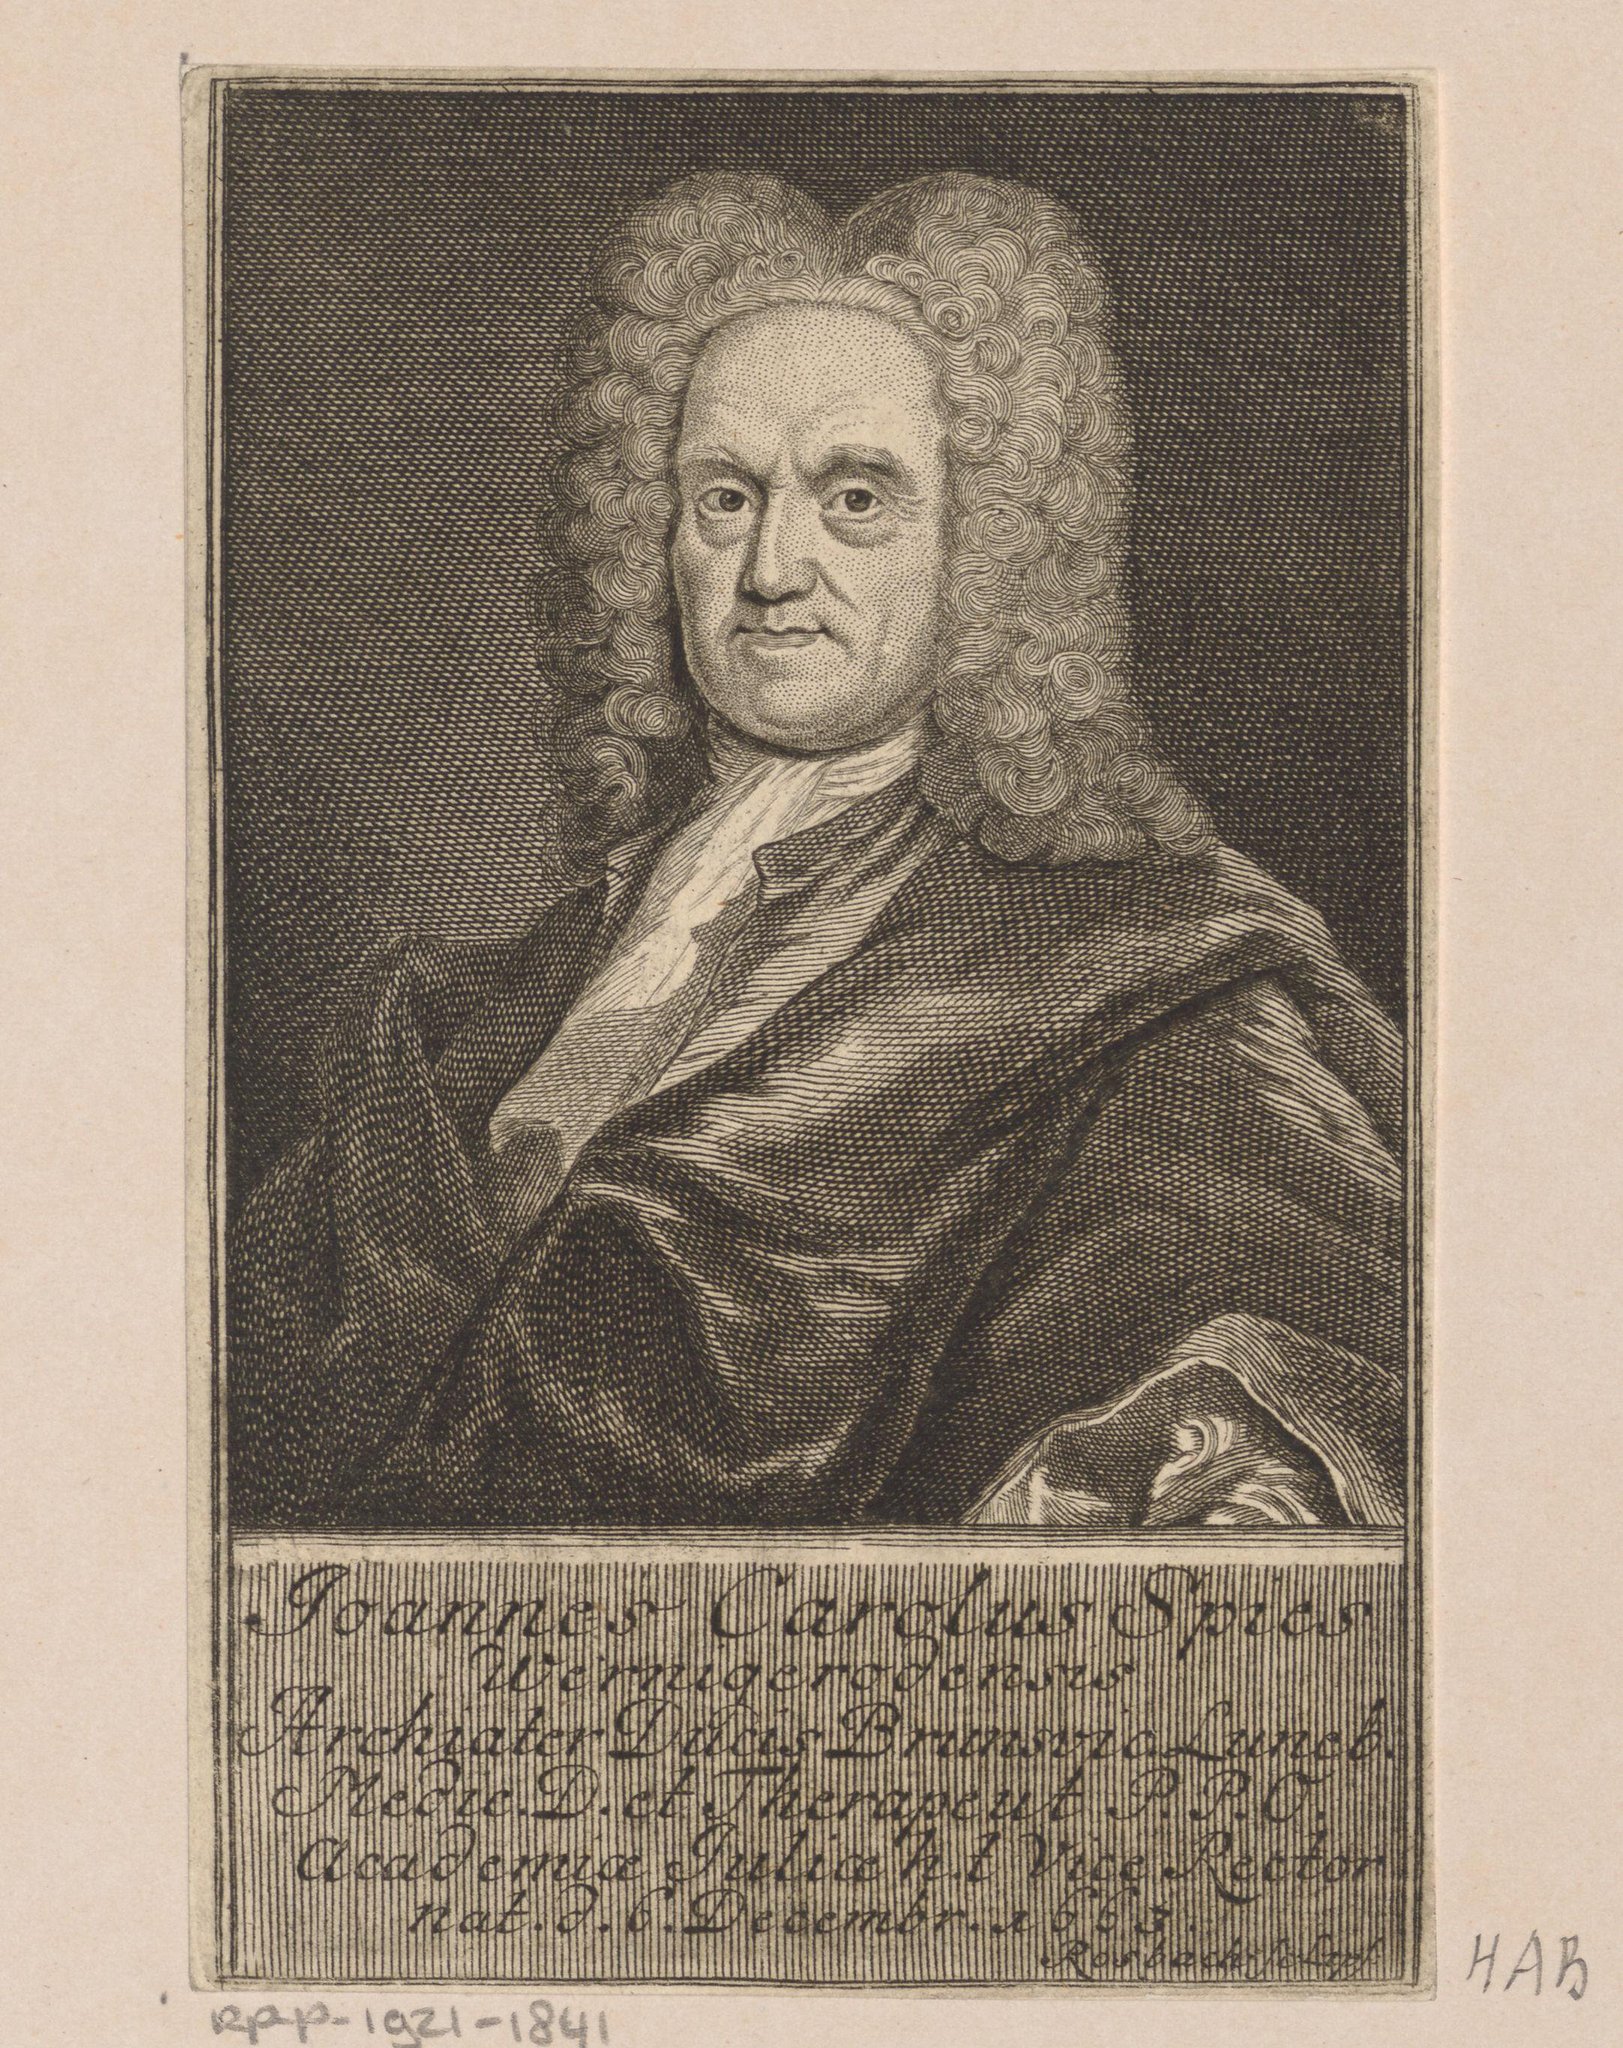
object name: print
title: Portret van Johann Carl Spies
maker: johann friedrich rosbach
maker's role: print maker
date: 1693-1799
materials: paper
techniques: engraving, etching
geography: leipzig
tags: historical persons, physician, doctor (+ portrait of scholar, scientist)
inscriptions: collector's mark: Lugt 2233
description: Met zesregelig onderschrift in het Latijn.